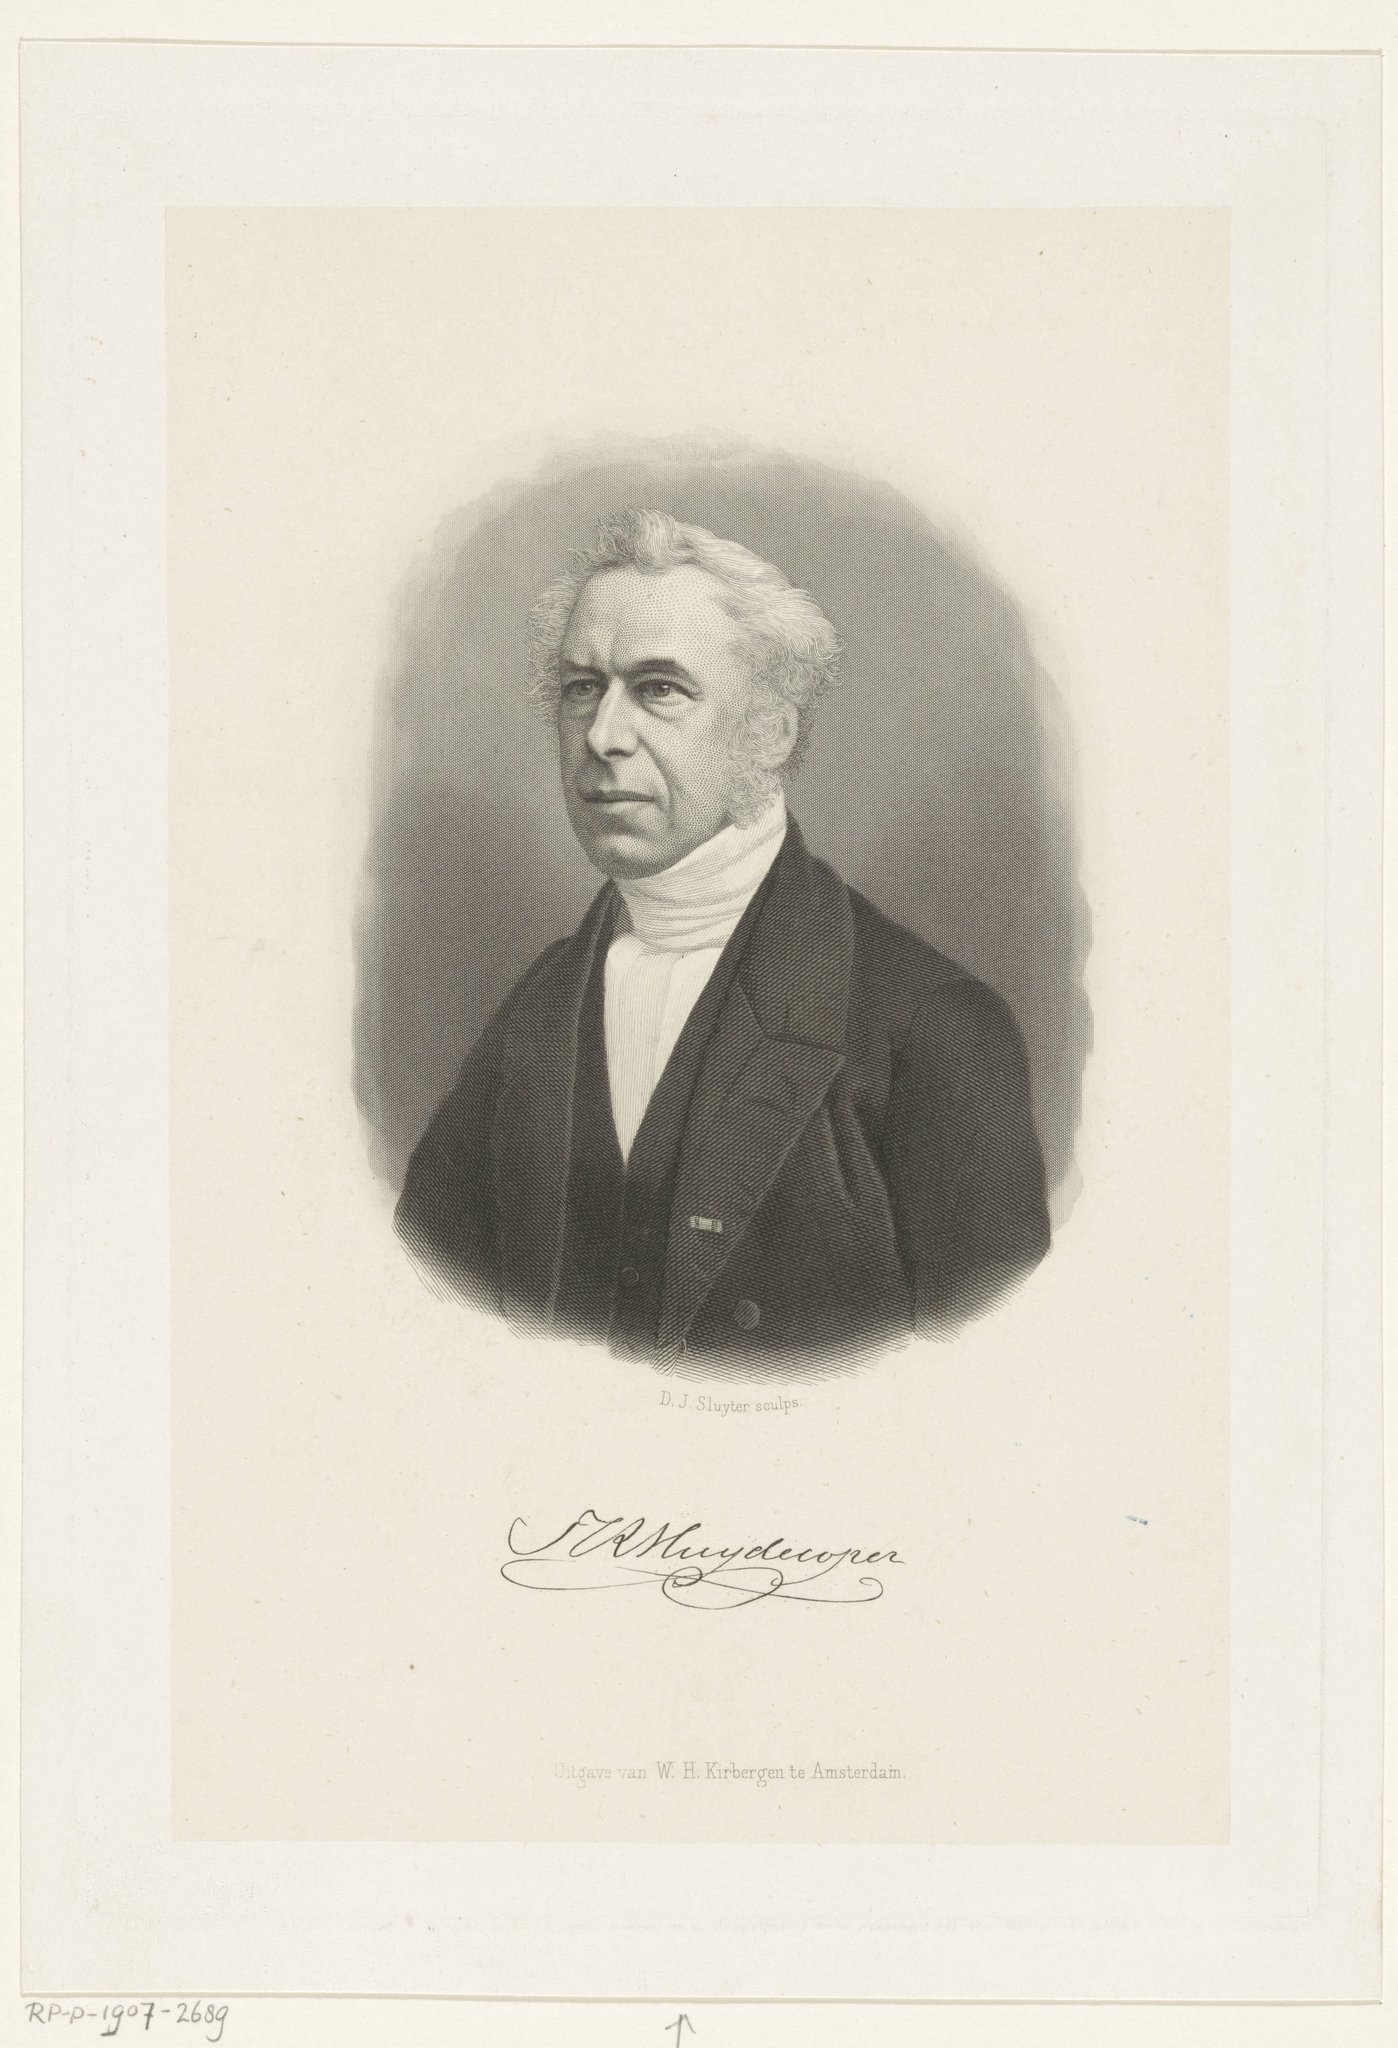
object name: print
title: Portret van de predikant Theodoor Cornelis Reinier Huydecoper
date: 1848-1885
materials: paper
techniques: etching, engraving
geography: amsterdam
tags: hoorn (north holland), the hague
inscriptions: collector's mark: Lugt 2228